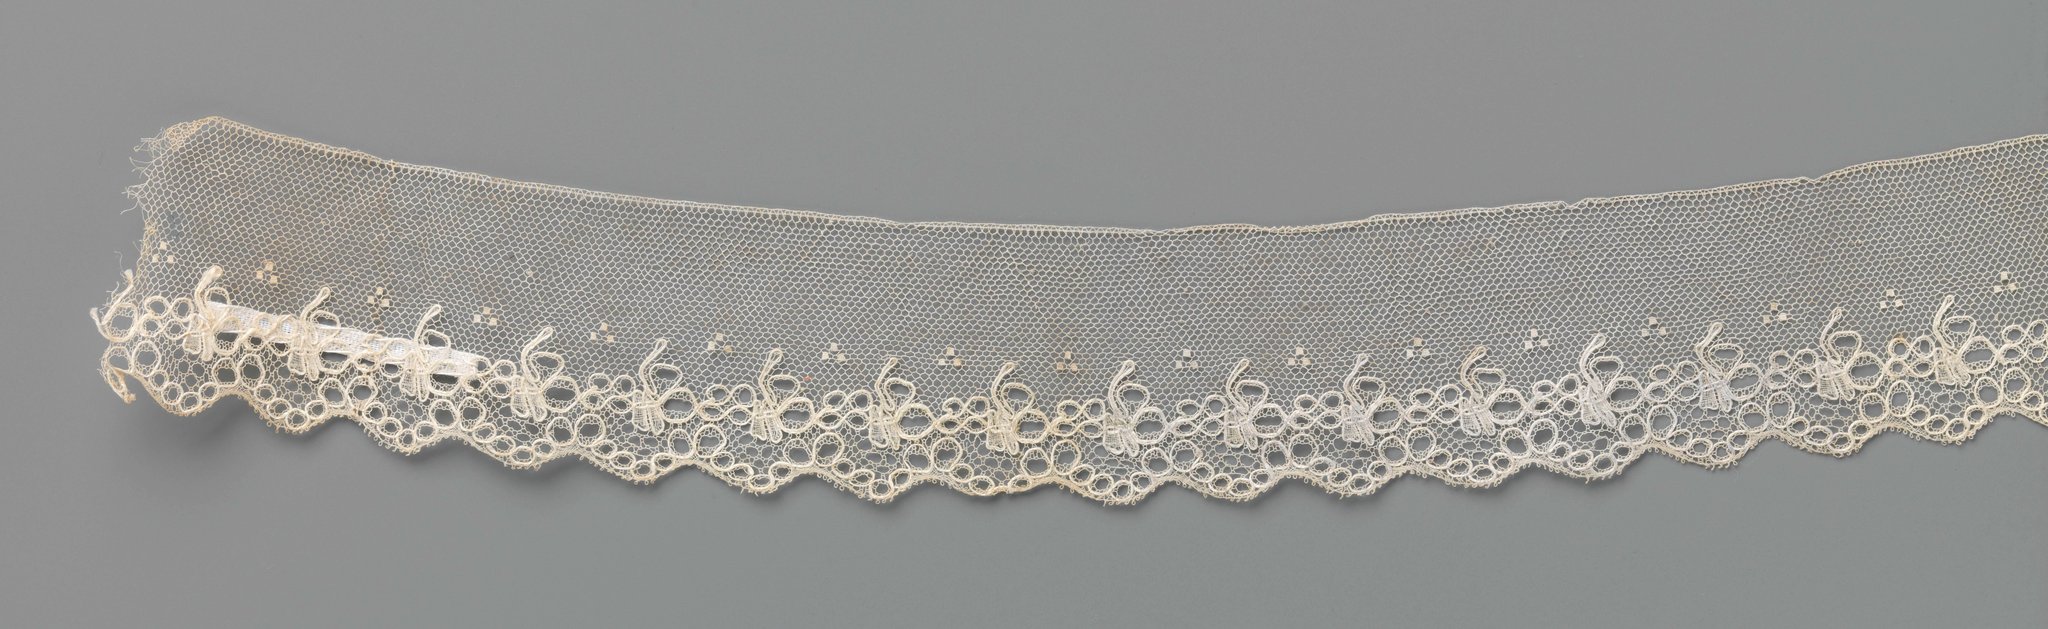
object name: strip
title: Strook kloskant met strikjes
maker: Anonymous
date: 1799-1800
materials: linen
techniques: lace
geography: southern netherlands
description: Strook naturelkleurige kloskant, Rijselse kant. Het zich herhalende en doorlopende patroon begint onder de middenlijn van de strook en bestaat uit een soort strikjes die met elkaar verbonden zijn door een configuratie van vier cirkeltjes, waarboven steeds een configuratie van drie moesjes is te zien. Een golvende lijn langs de onderzijde wordt gevormd door een aaneenschakeling van cirkeltjes, waarvan de twee cirkeltjes op de golfstoppen steeds iets groter zijn. De motieven zijn aan de bovenkant van het patroon met elkaar verbonden door een fijne maasgrond, een tulegrond. De moesjes zijn gemaakt in vormslag. De motiefjes zijn grotendeels gemaakt met een siergrond en omringd door dikkere en glimmende contourdraden. De bovenzijde is recht afgewerkt. De golvende lijn vormt de schulpjes langs onderzijde, die zijn afgewerkt met picots.